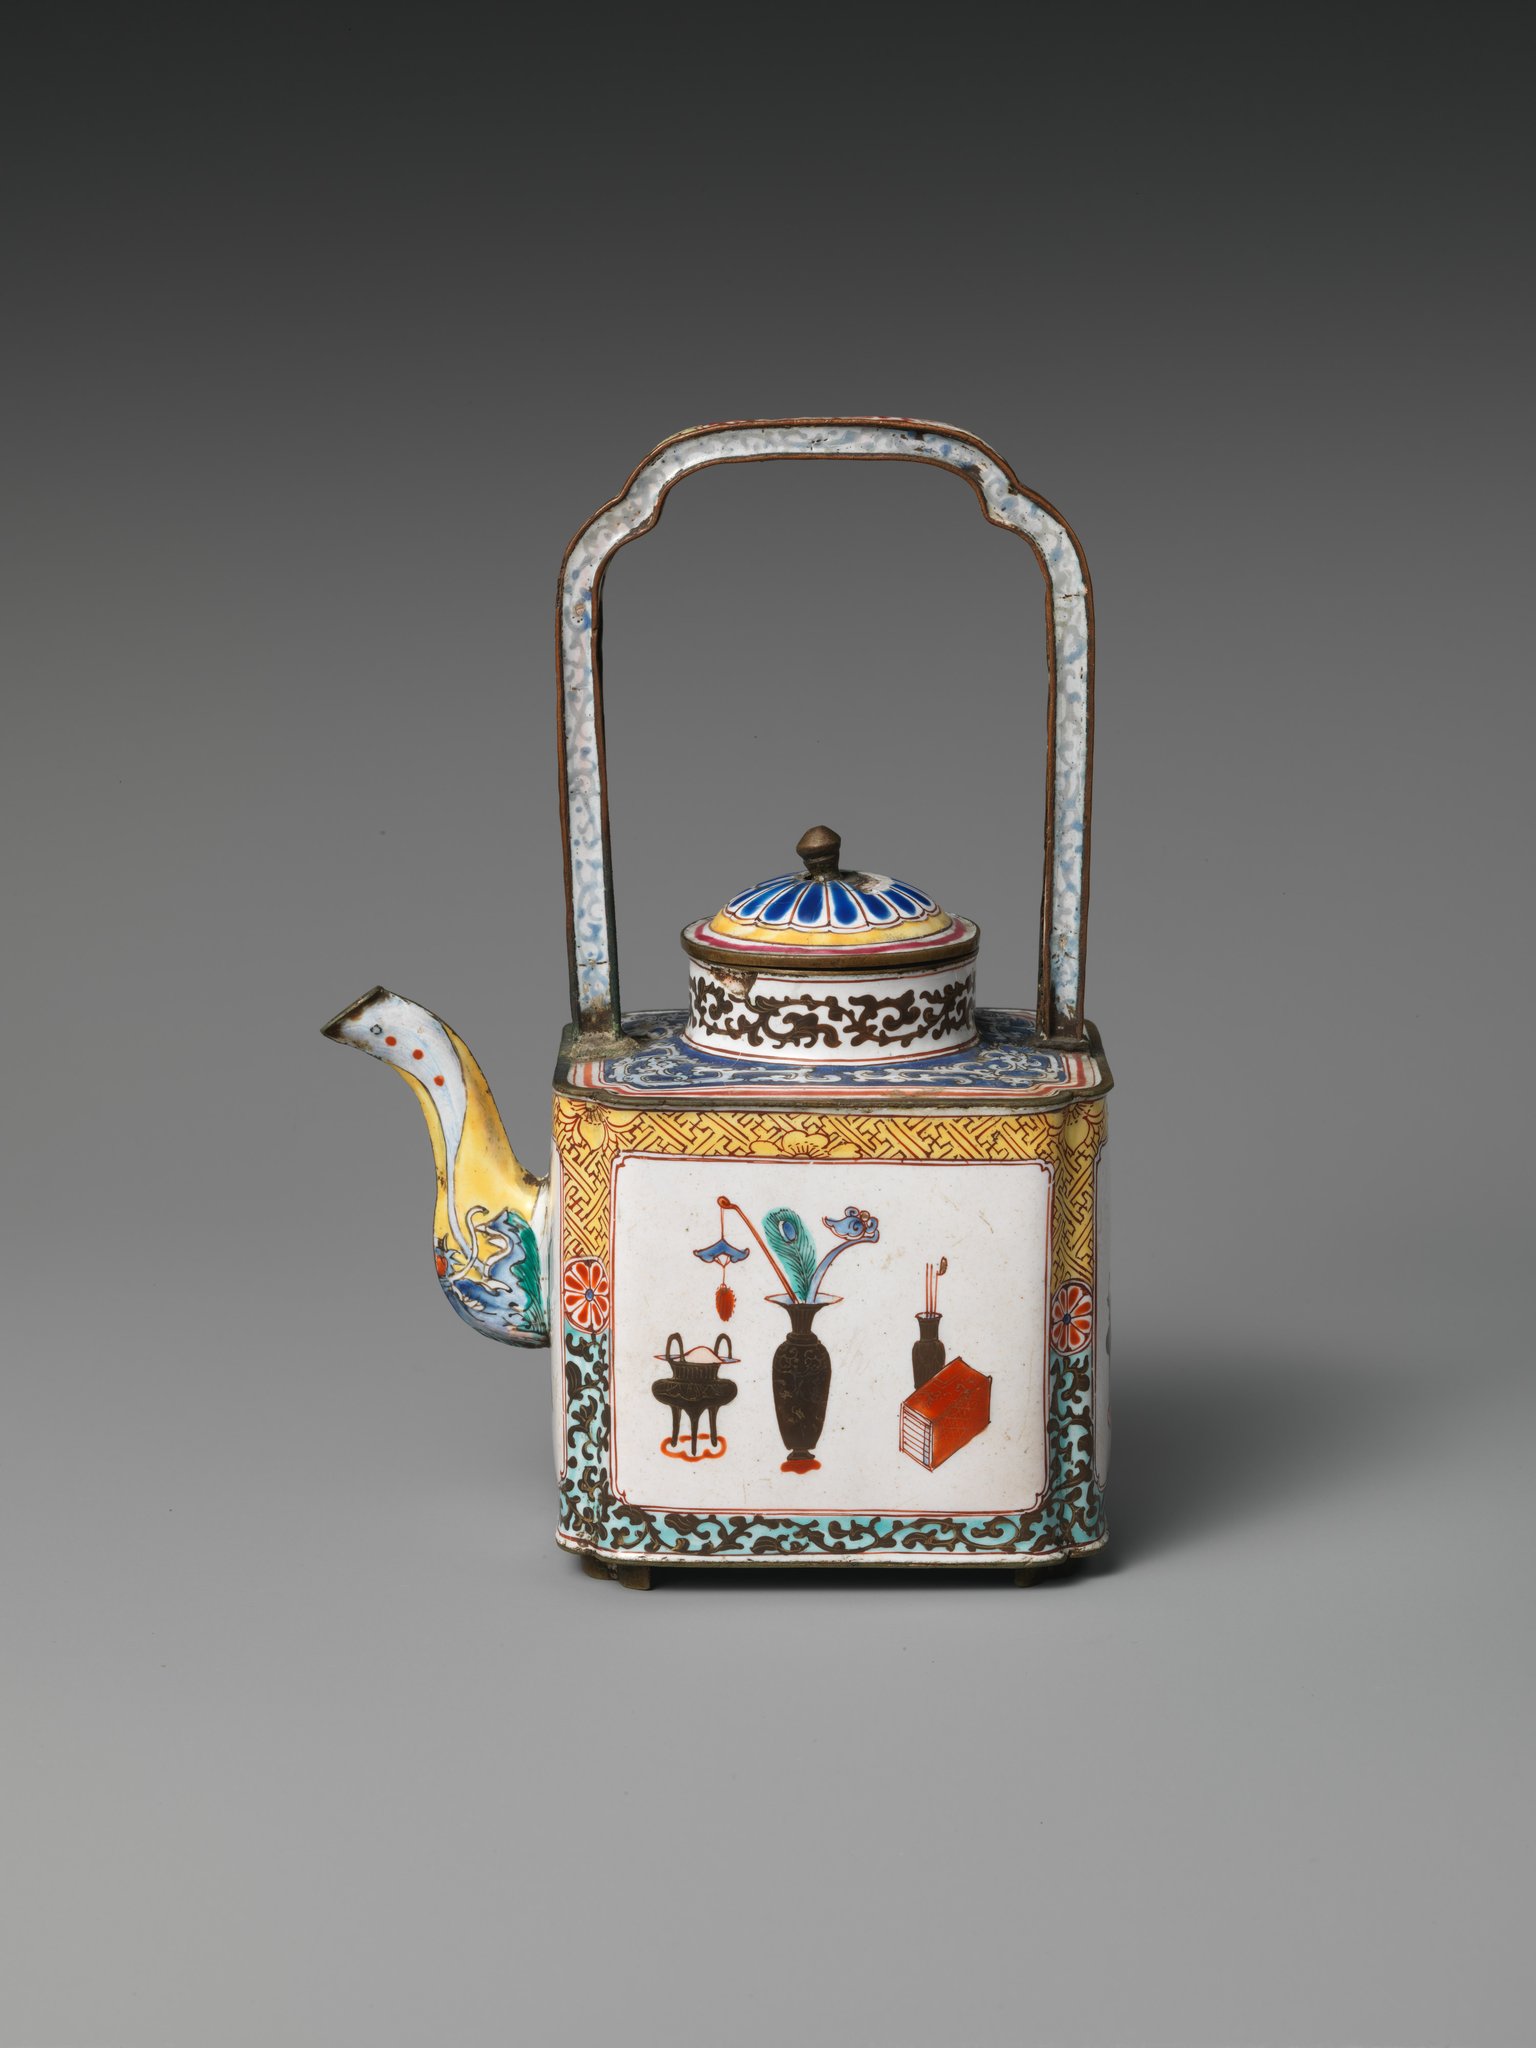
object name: teapot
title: Teapot with Pattern of the "Hundred Antiques"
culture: chinese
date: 1801-1900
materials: enamel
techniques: painting